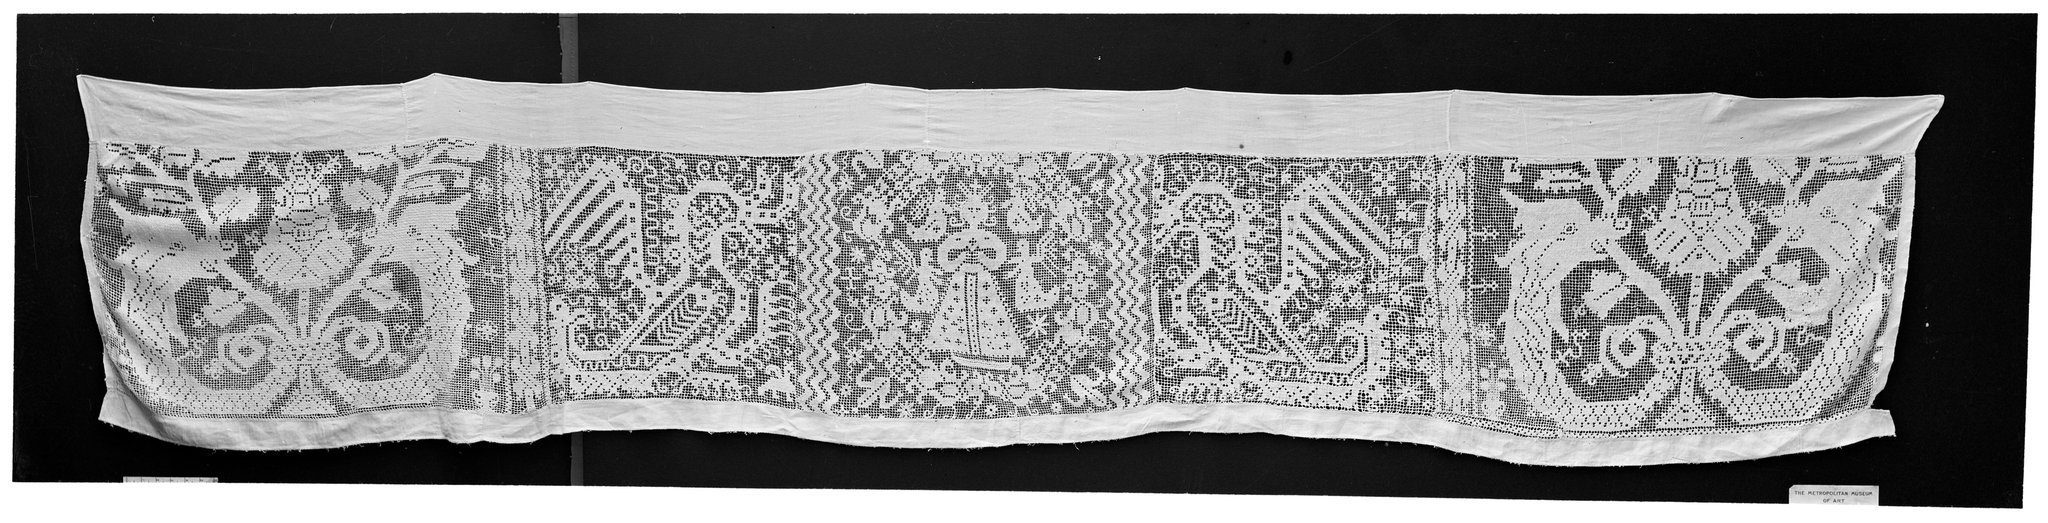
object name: antependium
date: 1701-1800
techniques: embroidery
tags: virgin mary